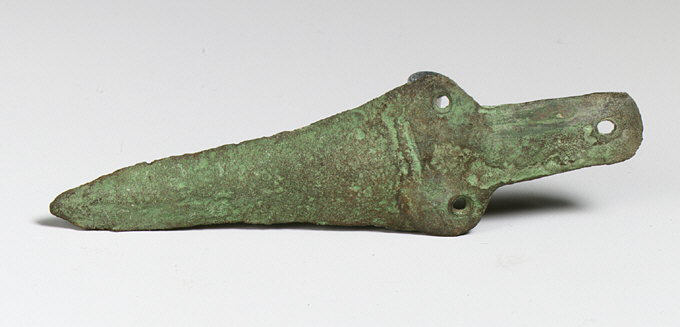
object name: dagger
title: Copper alloy dagger blade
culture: cypriot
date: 2500-1050 BCE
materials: bronze